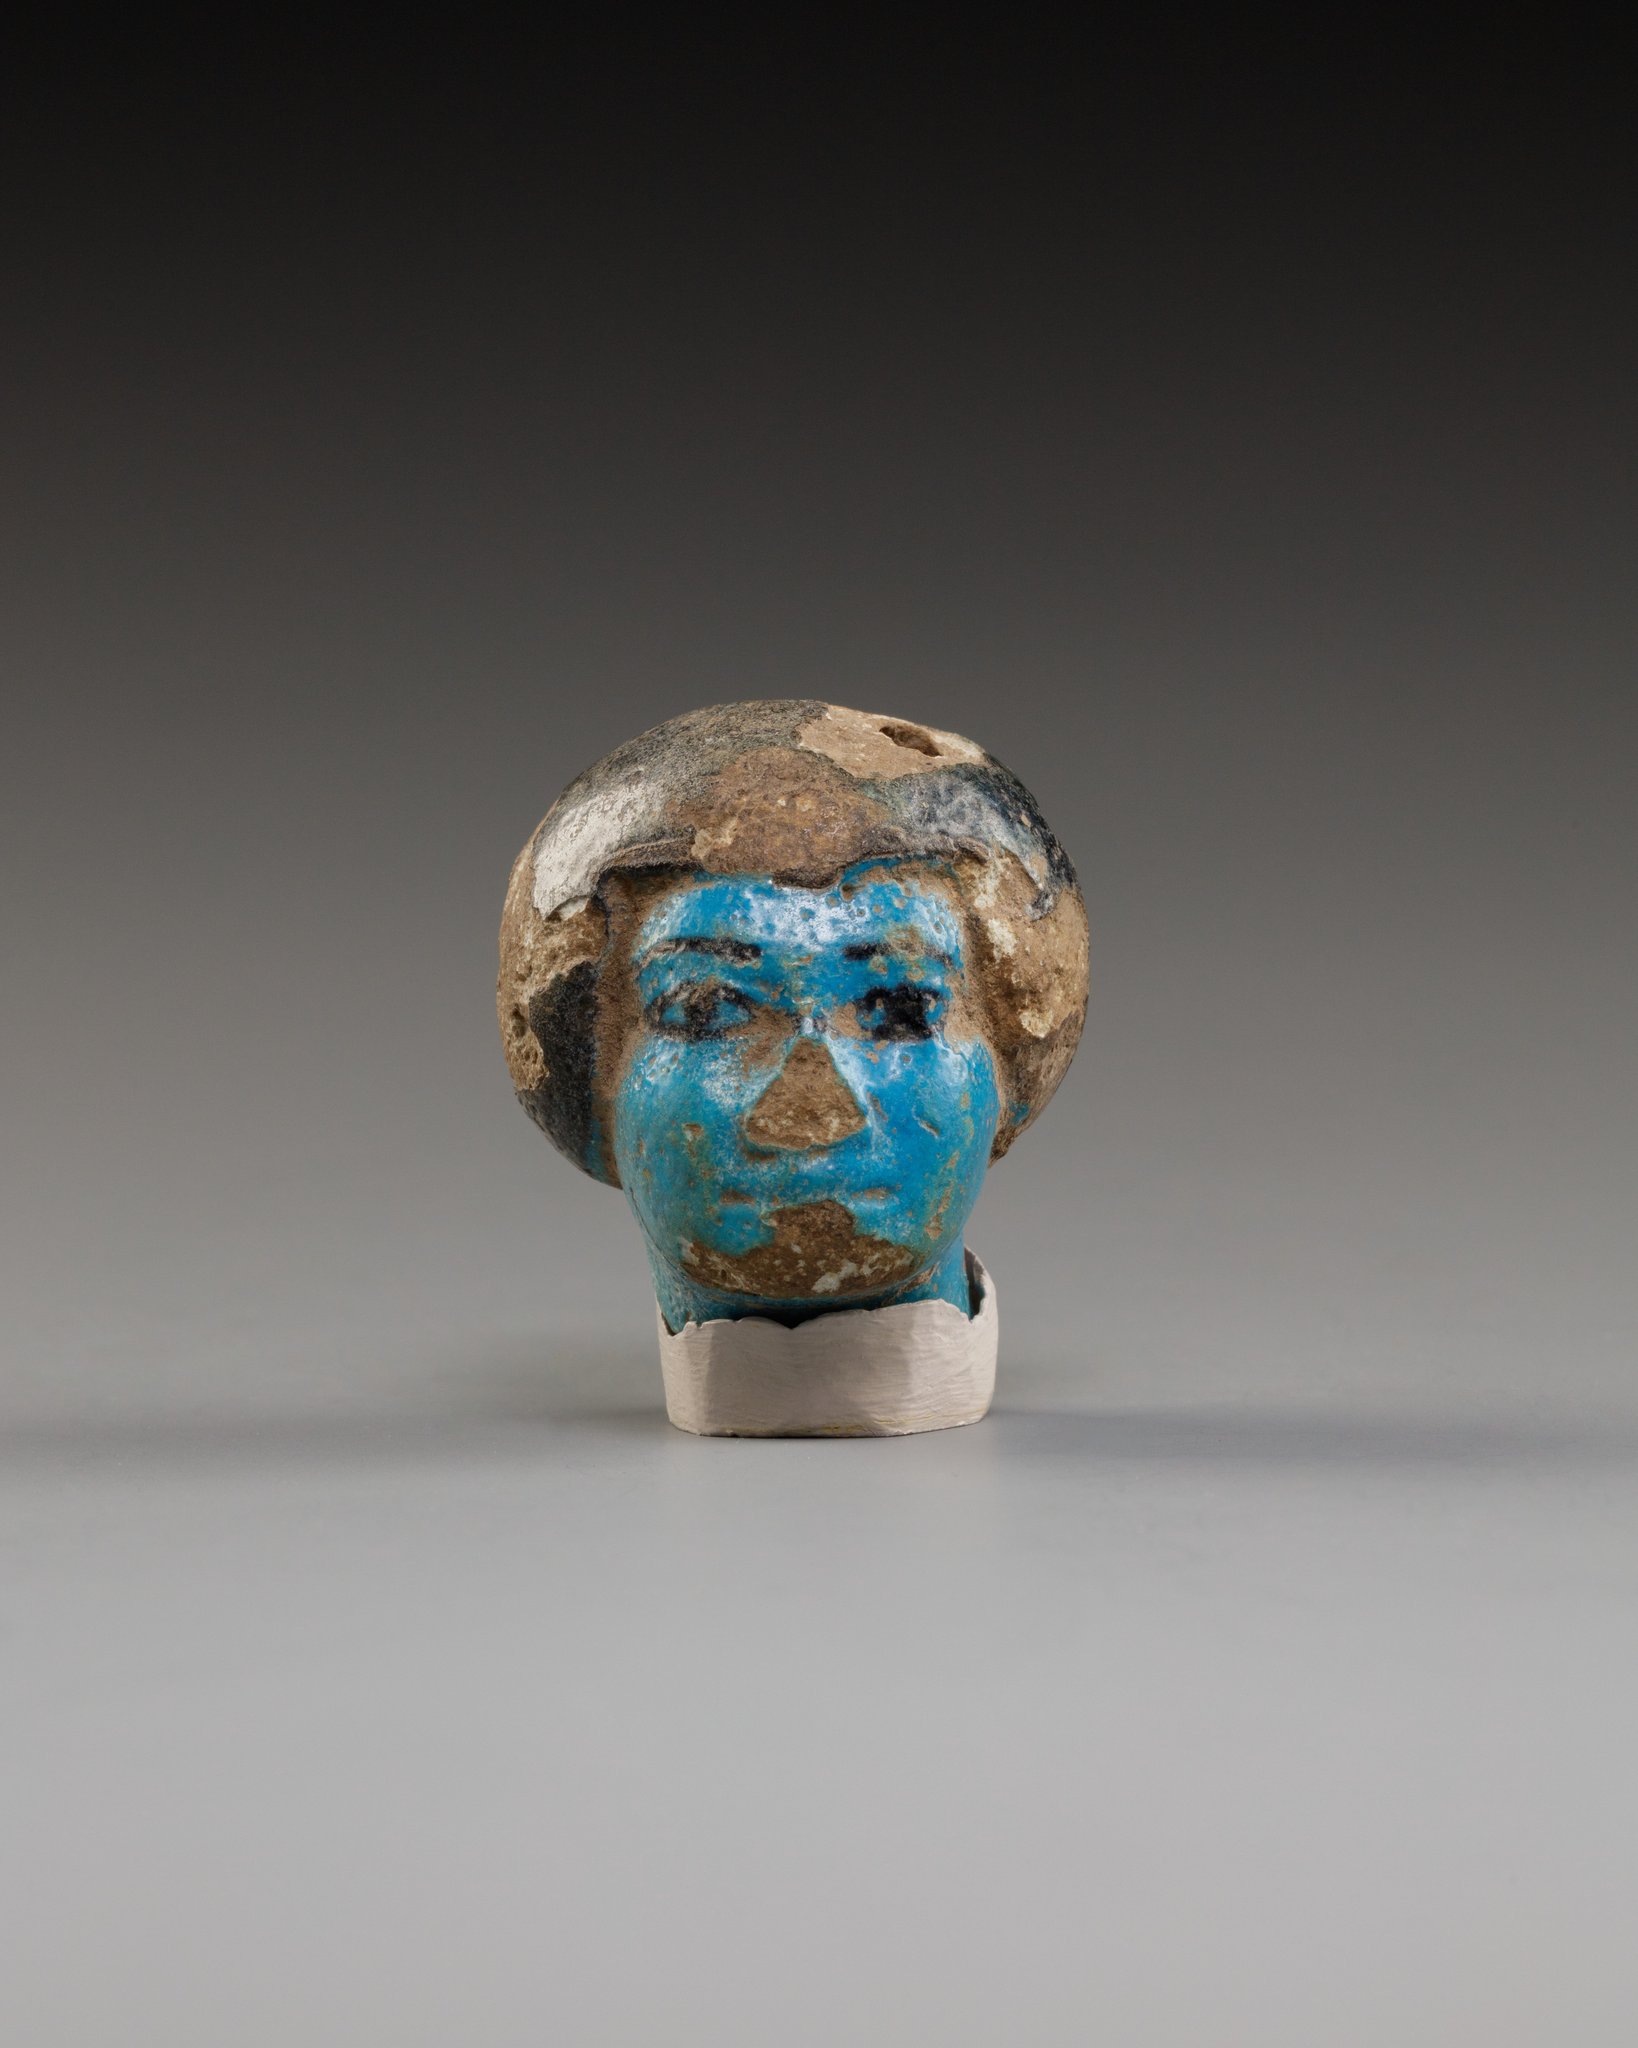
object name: figurine, head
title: Figurine of head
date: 1981-1640 BCE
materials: faience, pigment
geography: egypt